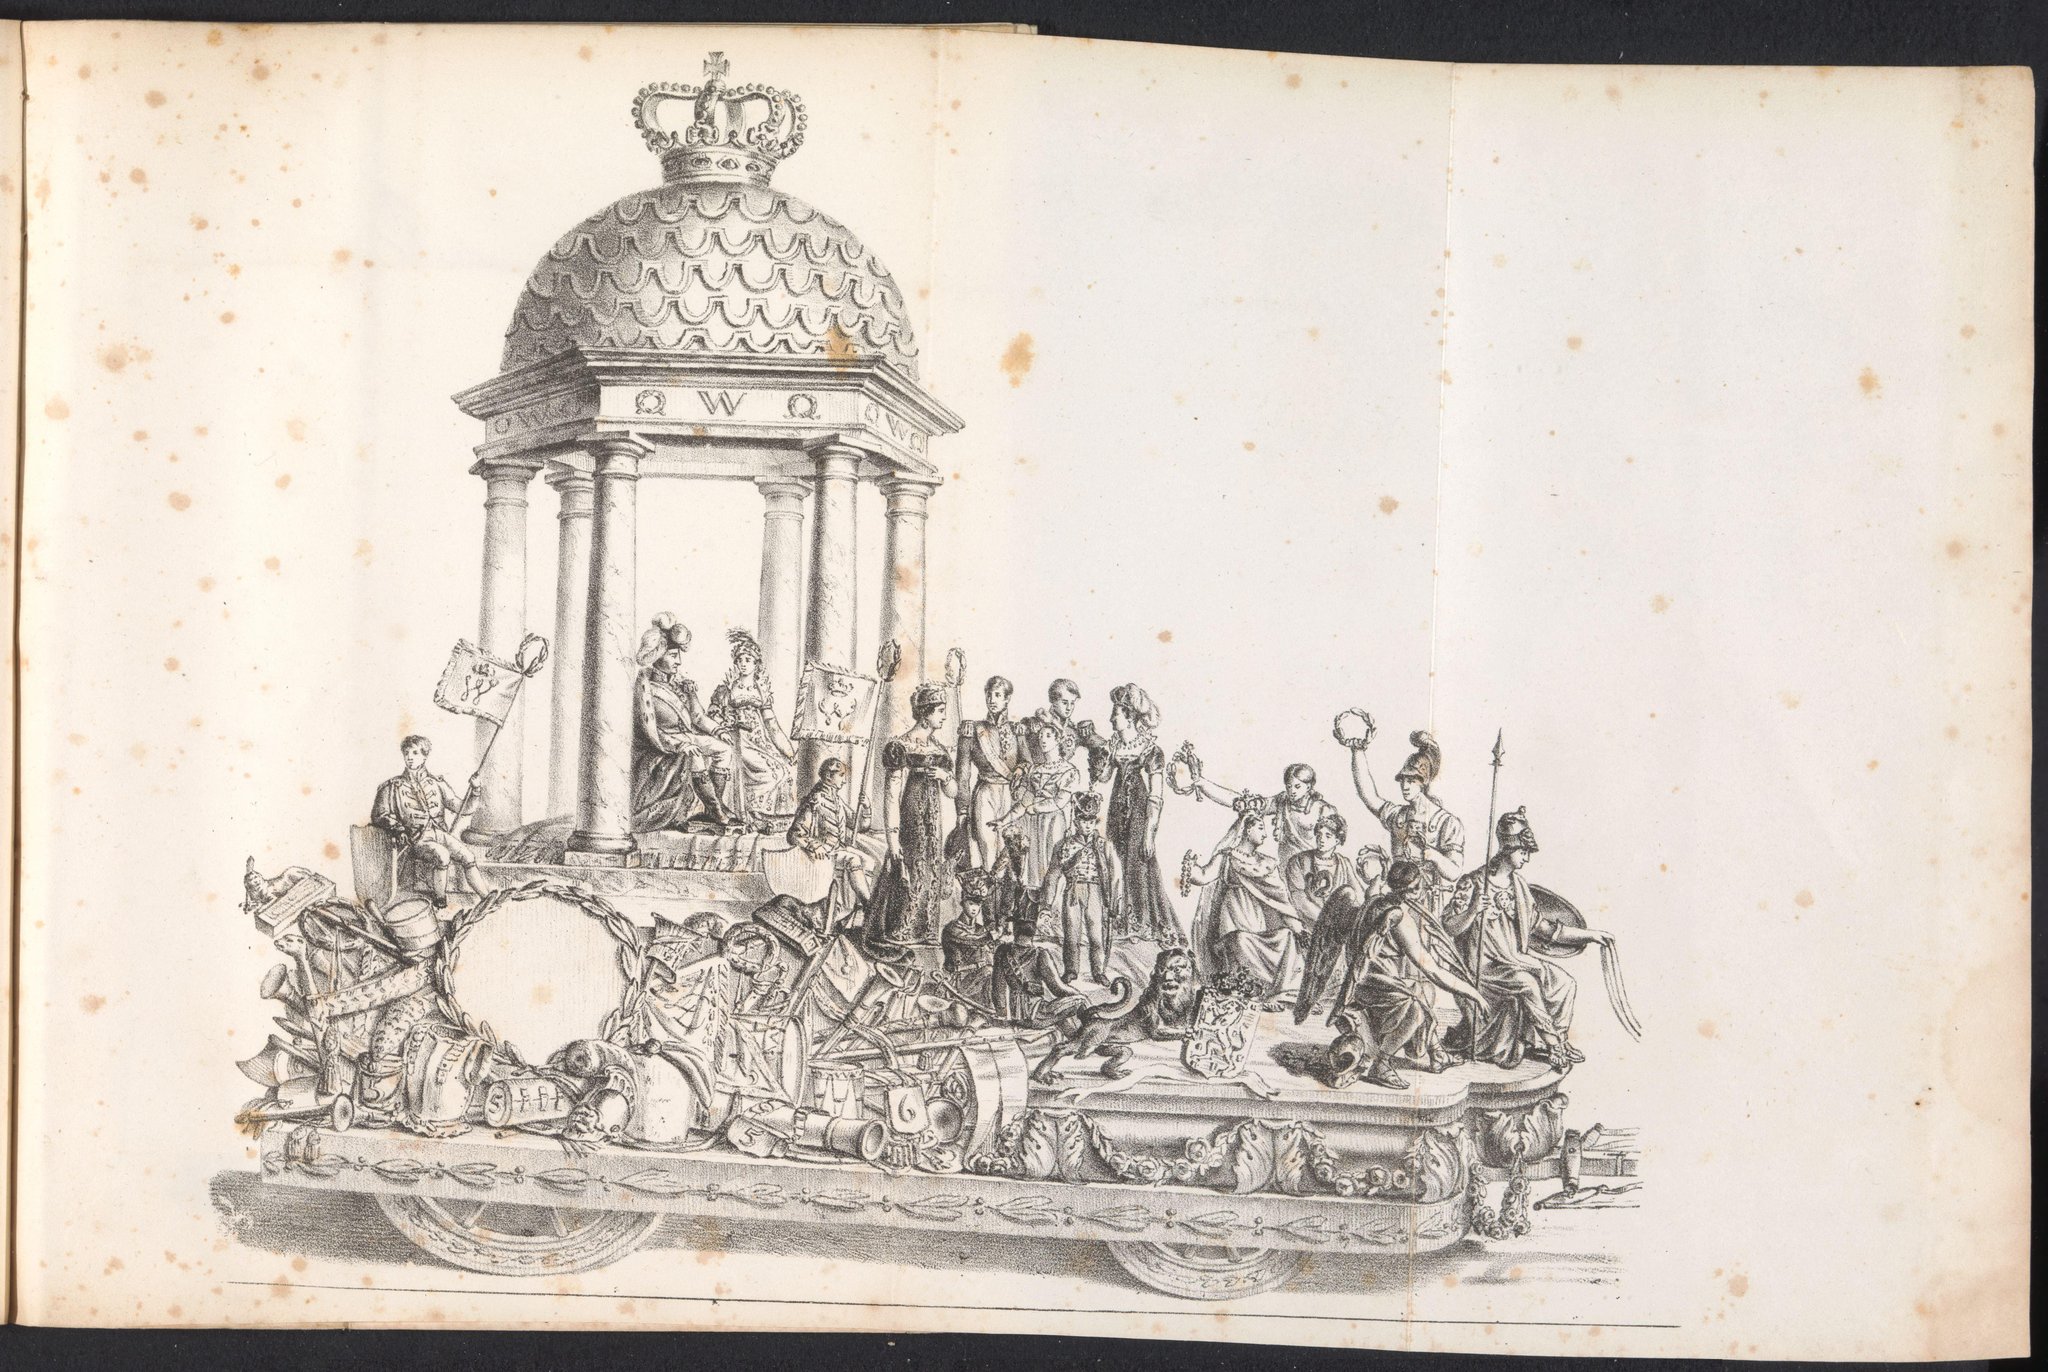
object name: print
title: Vijfde praalwagen in de optocht voor de Heilige Rombout, 1825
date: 1825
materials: paper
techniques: lithograph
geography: mechelen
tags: anna paulowna romanowa, the hague, william i of the netherlands, william ii of the netherlands, berlin, frederik (prins der nederlanden), wilhelmina frederica louisa (koningin der nederlanden), rejoicing on special occasions (+ parade, pageant, cavalcade ~ festive activities), the hermit, martyr, and possibly former bishop of dublin, rum(b)old (rombaut) of malines; possible attributes: axe, hoe - post-mortem occurrences ~ male saint, procession ~ christian religion, mechelen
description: De vijfde praalwagen in de ommegang voor de Heilige Rombout. De wagen gewijd aan het Huis Oranje-Nasssau. Bovenaan in een tempel zitten de koning en koningin, daarvoor de prinsen en prinsessen begeleid door enige Deugden. De optocht werd gehouden op 28 juni, 5 en 12 juli 1825. Illustratie in een publicatie ter gelegenheid van de 1050-jarige viering in 1825 van de dood van de Heilige Rumoldus of Rombout, patroonheilige van de stad Mechelen, van wie werd gedacht dat hij in 775 was overleden.